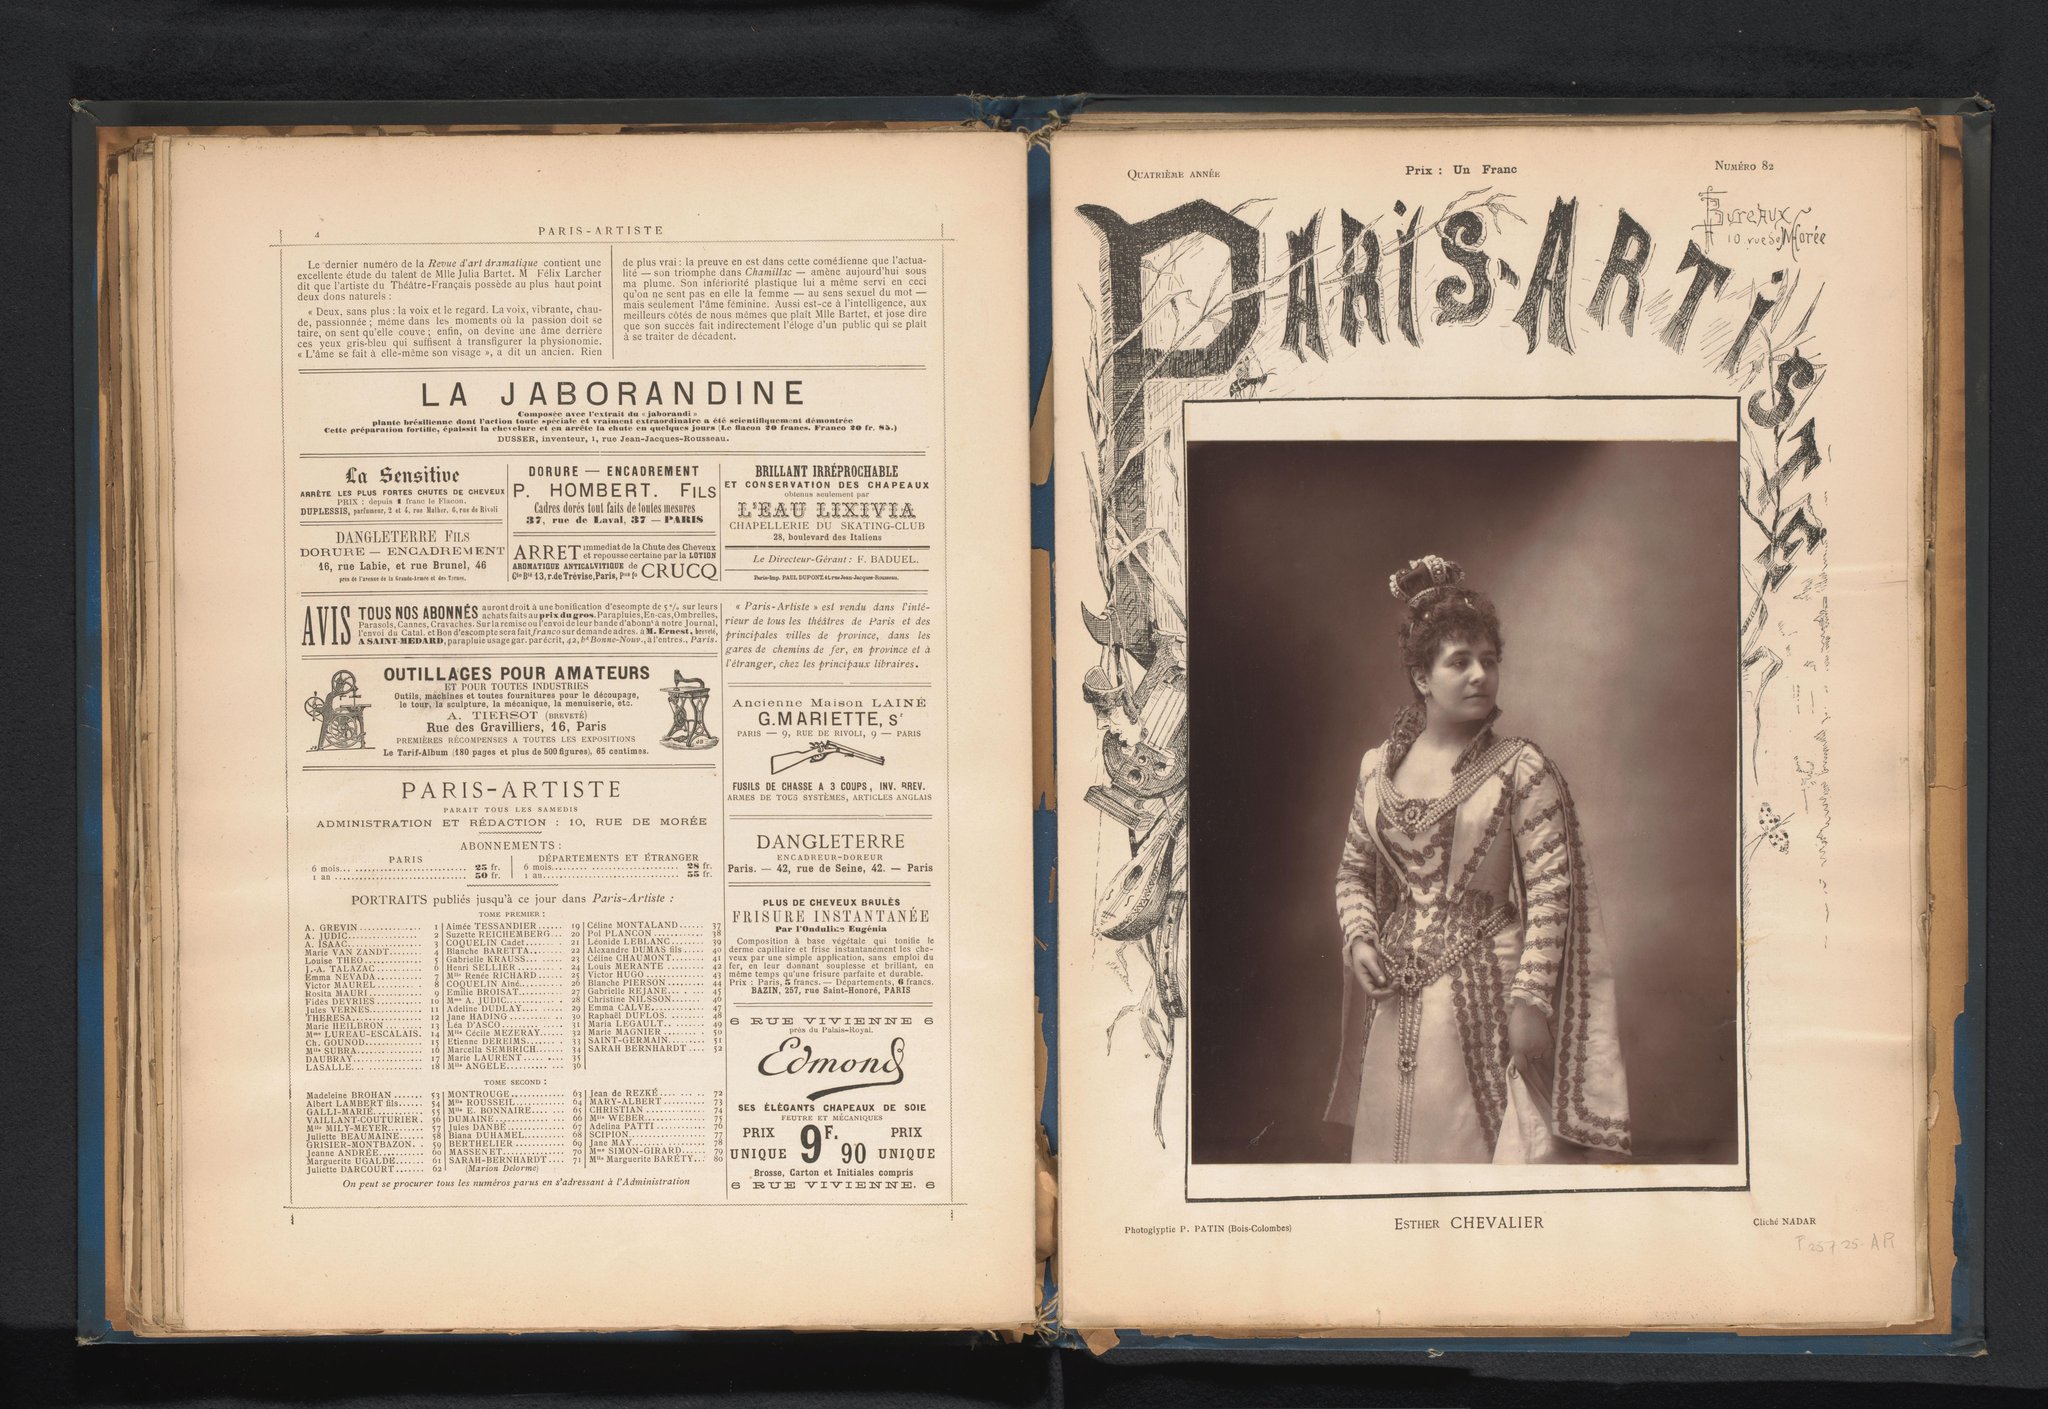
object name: photomechanical print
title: Portret van Esther Chevalier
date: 1880-1886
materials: paper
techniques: woodburytype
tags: historical persons - bb - woman, portrait of actor, actress